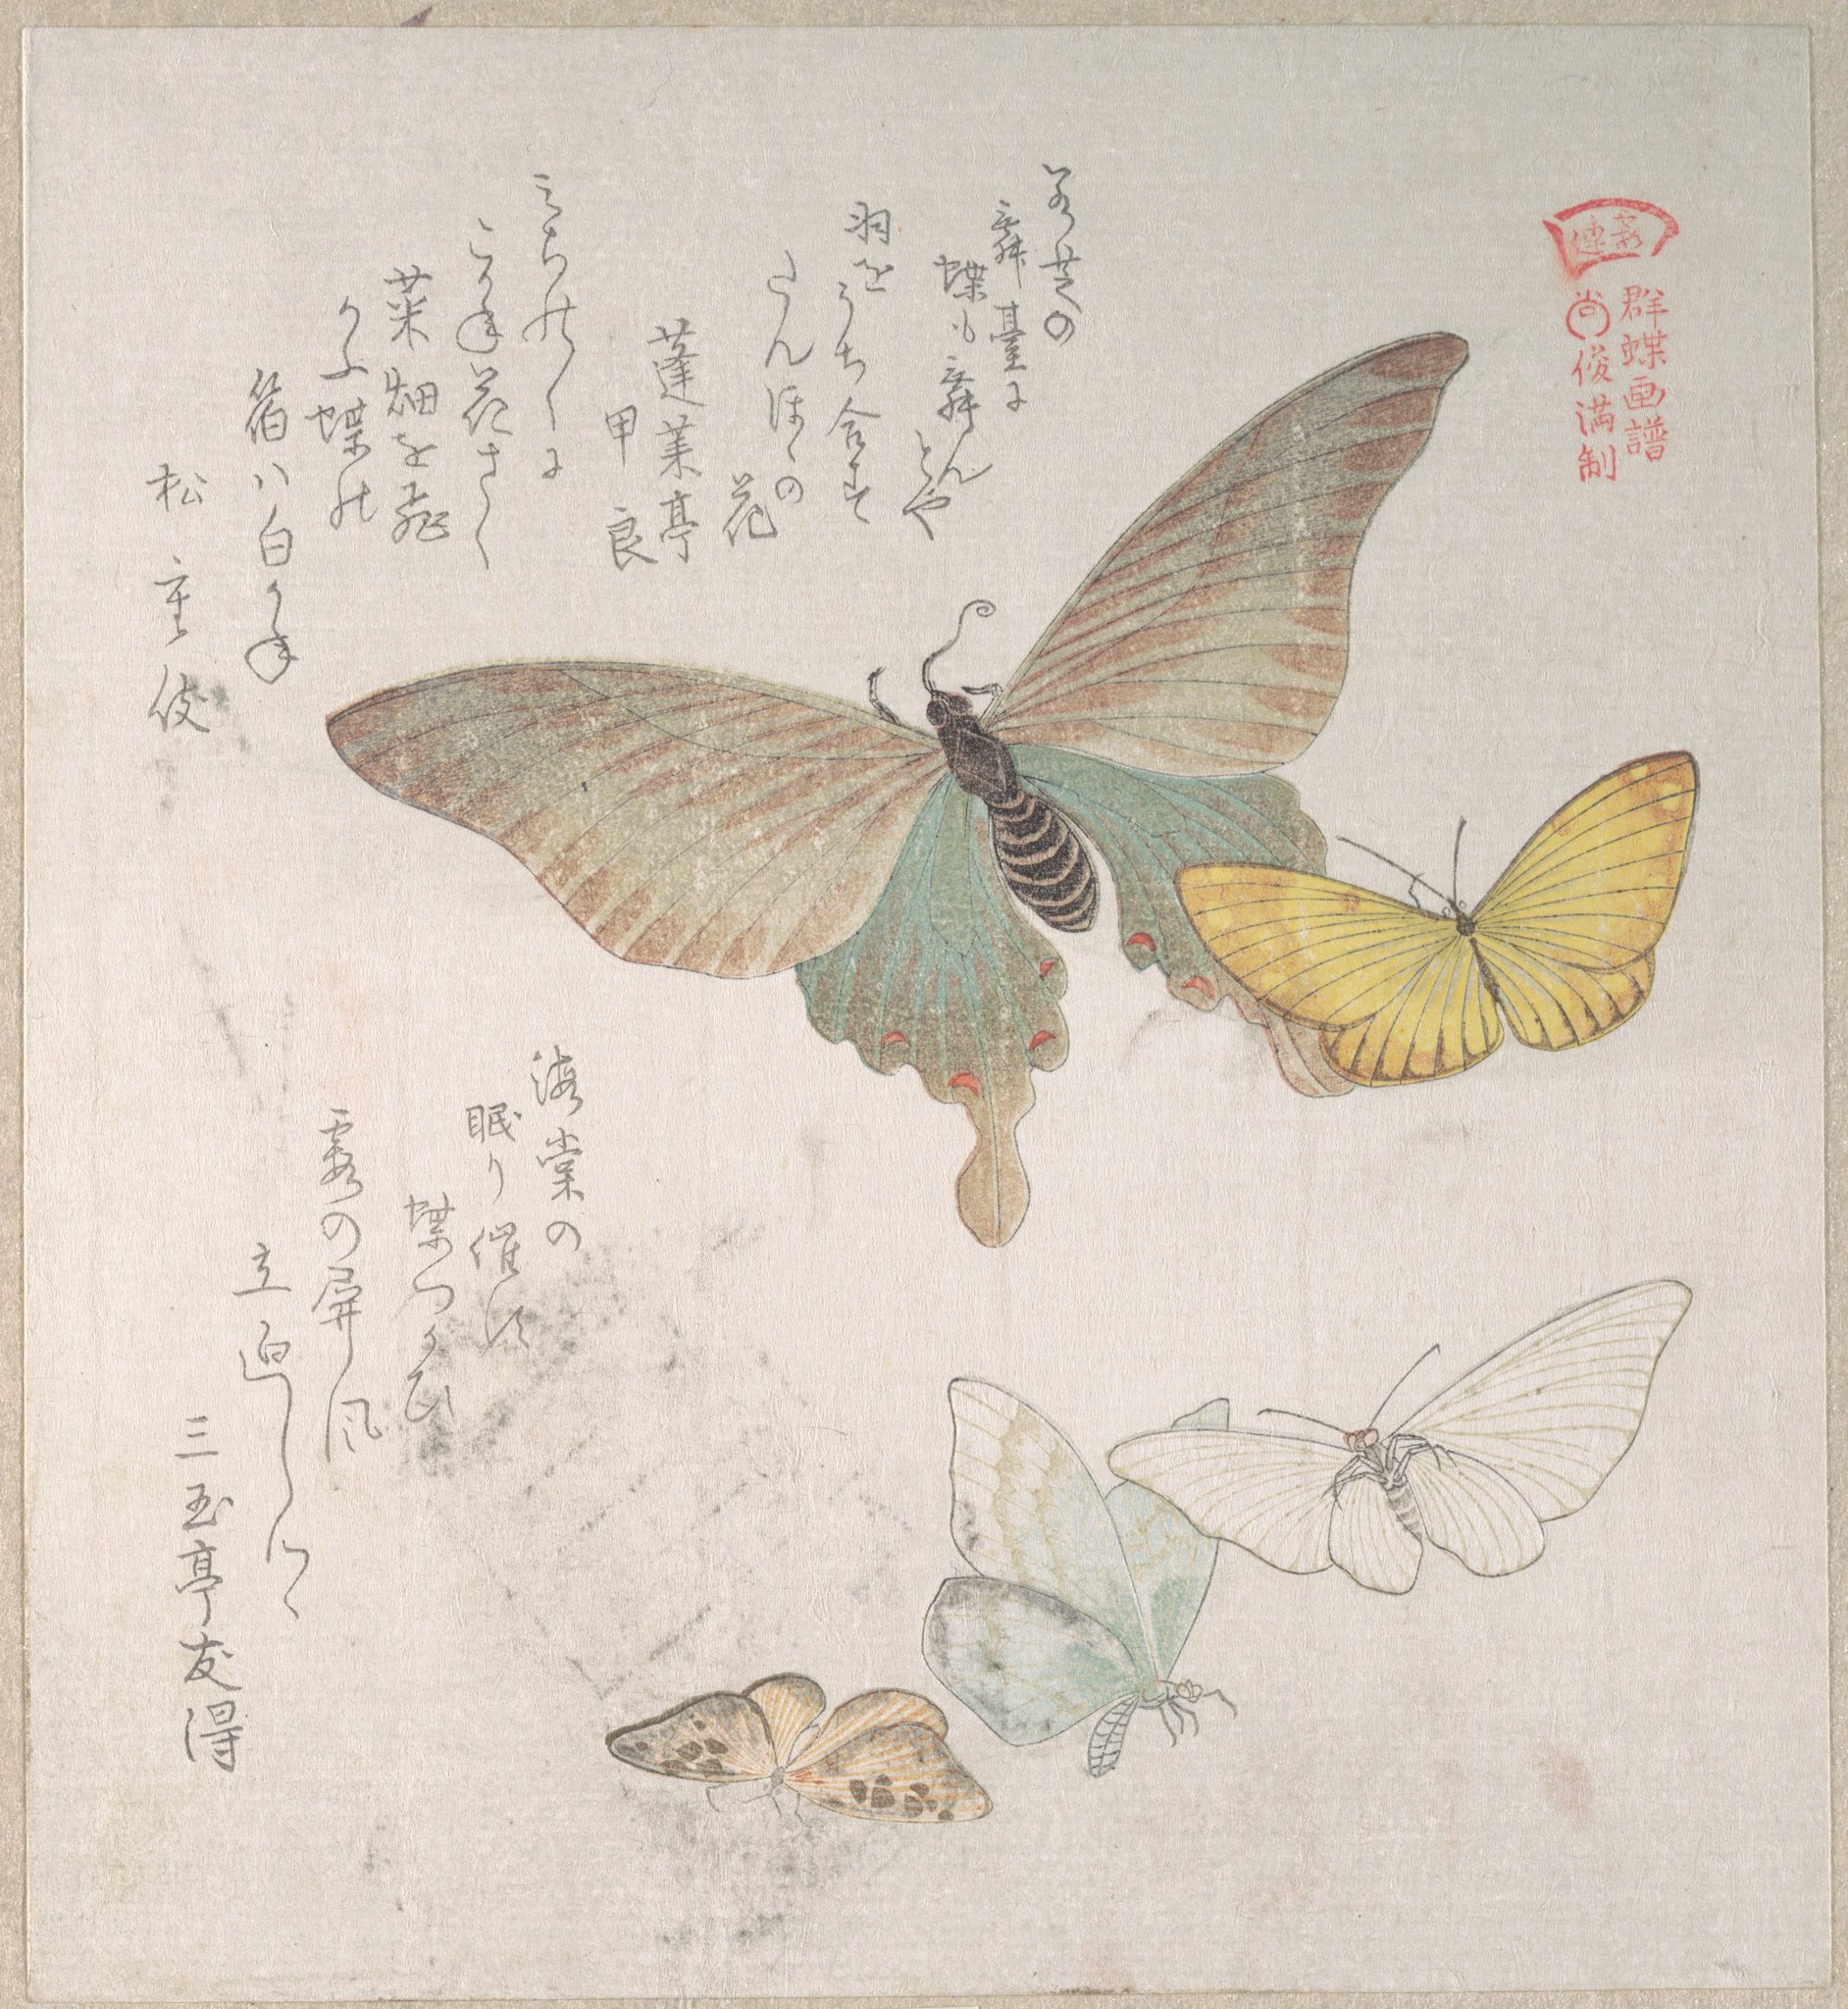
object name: print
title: Various Moths and Butterflies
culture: japanese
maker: kubo shunman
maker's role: artist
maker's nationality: japanese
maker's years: 1757-1820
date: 1801-1900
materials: ink, paper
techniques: surimono, woodblock print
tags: insects,butterflies